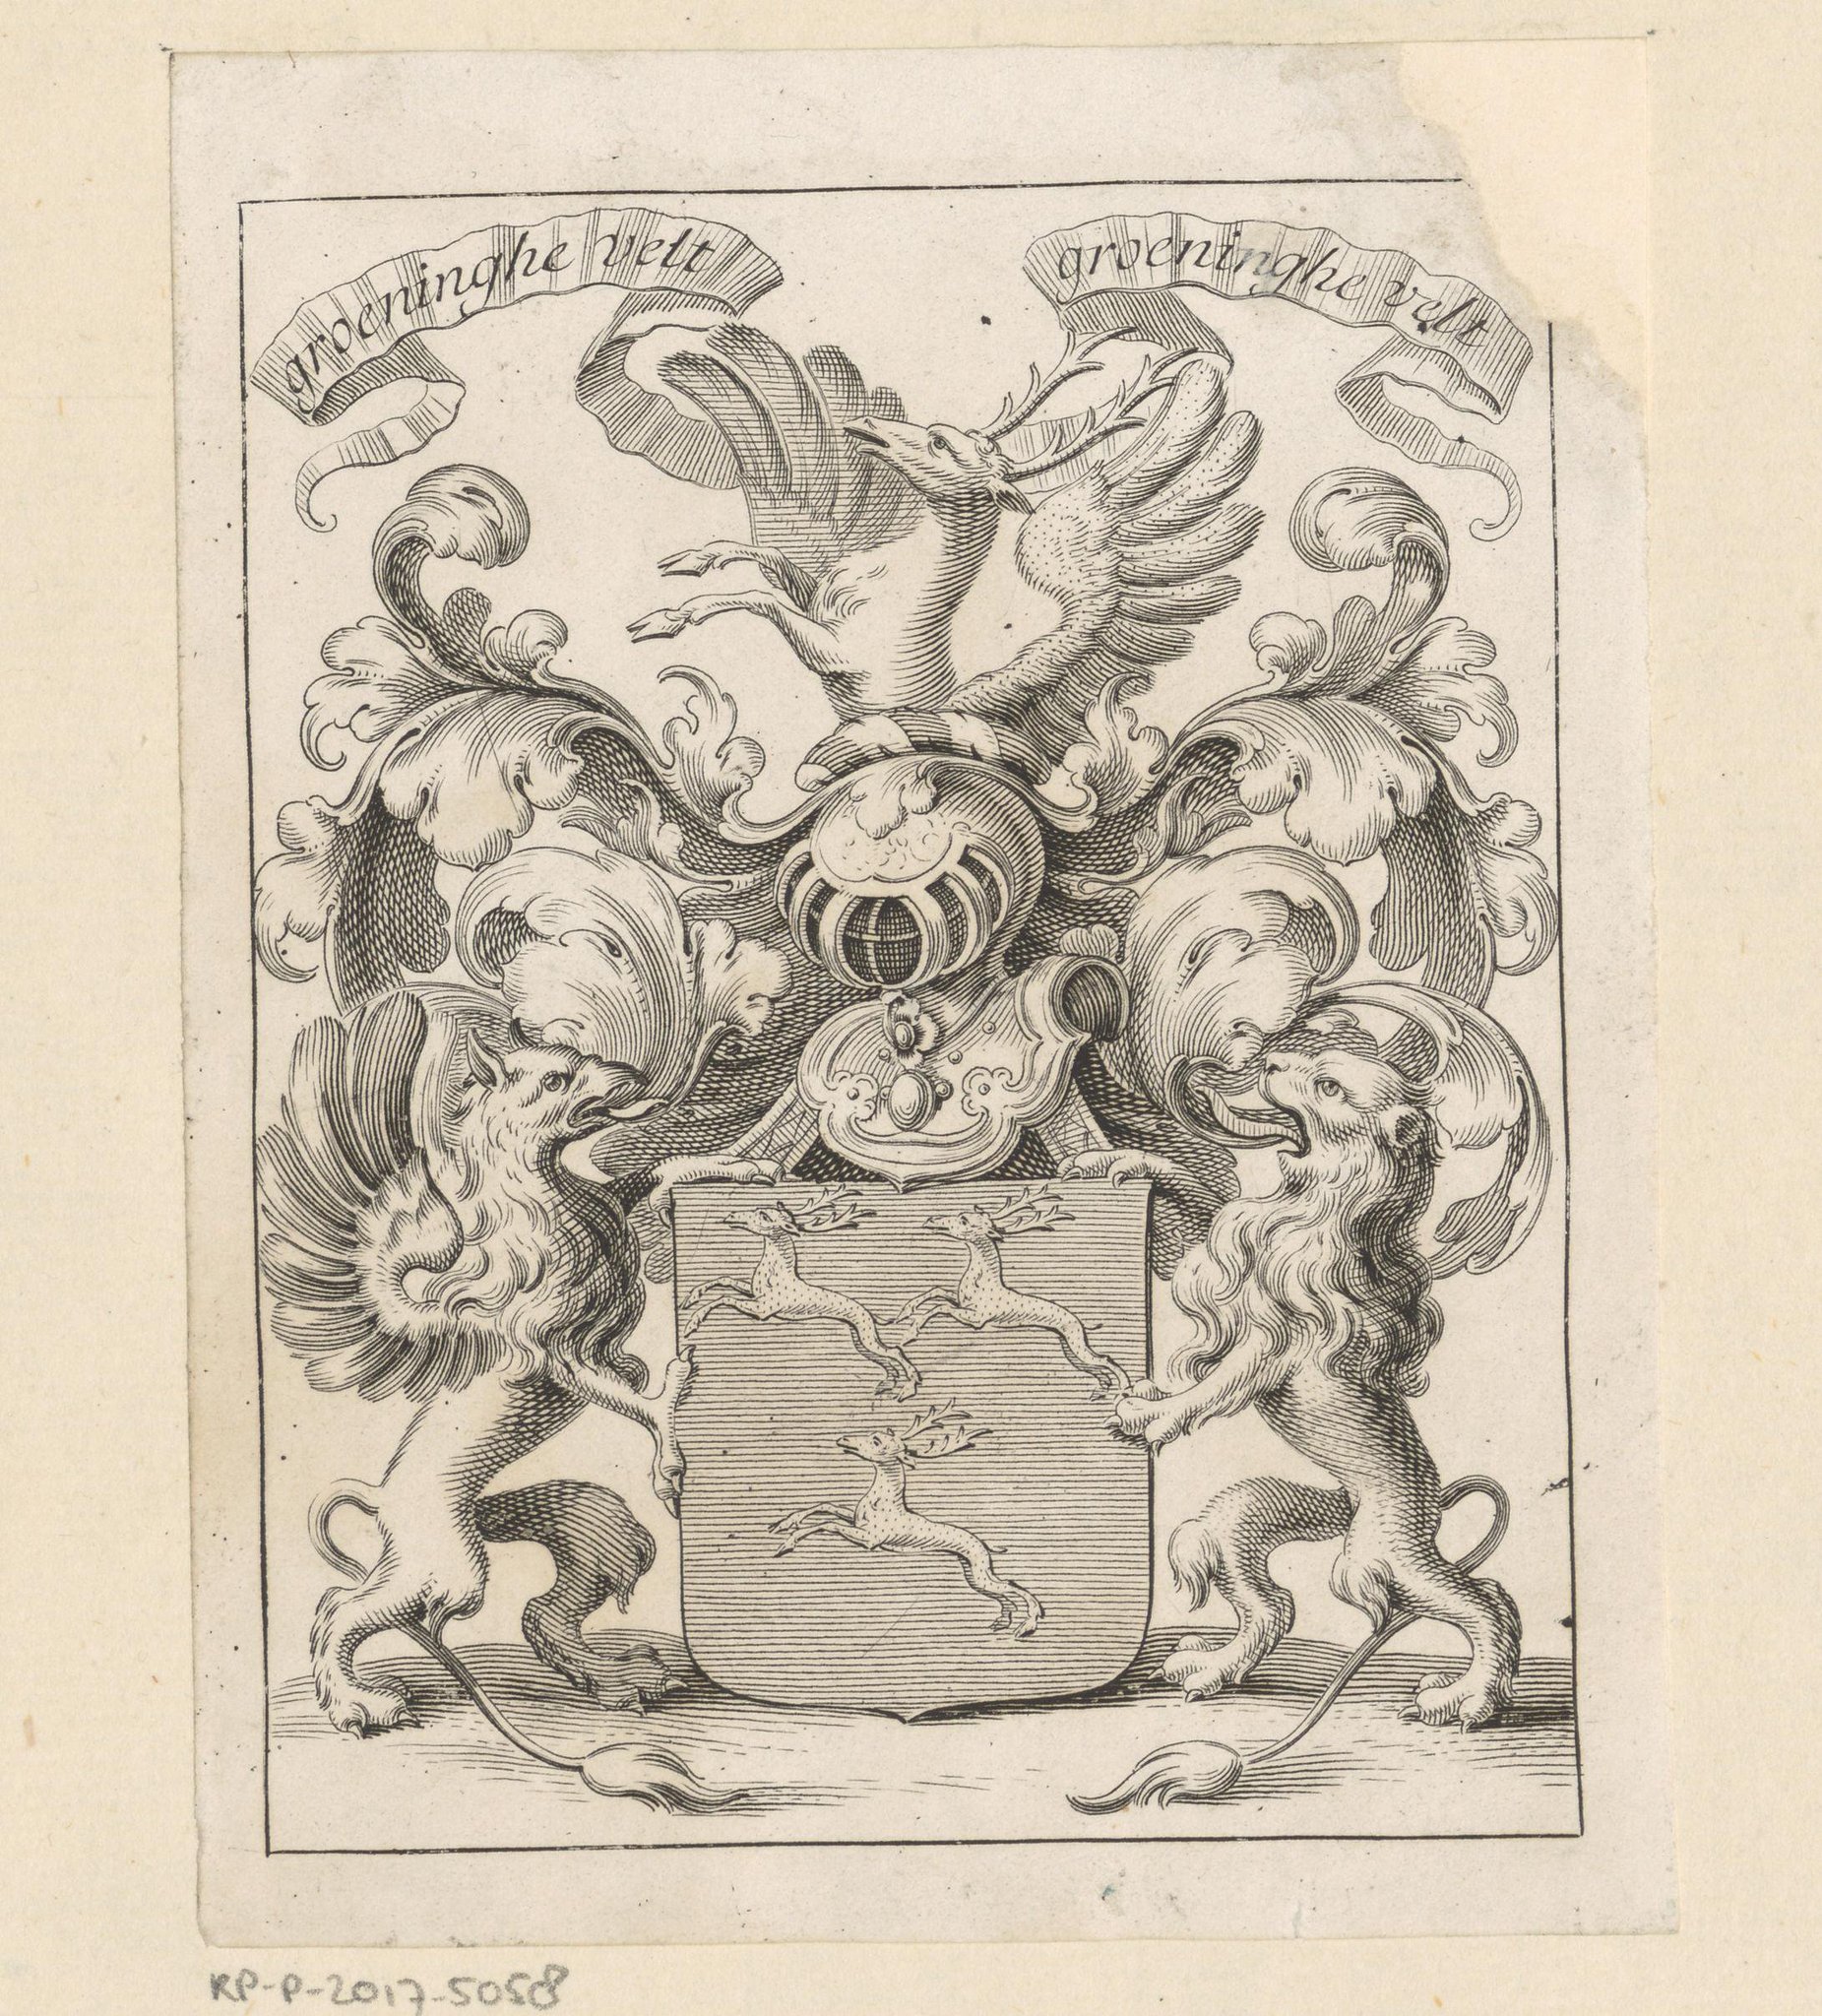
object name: bookplate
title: Ex libris van de familie Borluut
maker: Anonymous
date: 1700-1849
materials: paper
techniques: engraving, etching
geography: belgium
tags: griffin (lion/eagle); 'griffo' (ripa), hoofed animals: deer, beasts of prey, predatory animals: lion, armorial bearing, heraldry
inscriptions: collector's mark: Lugt 2233, inscription: ‘Inv. Boeken 1890 / 2805’